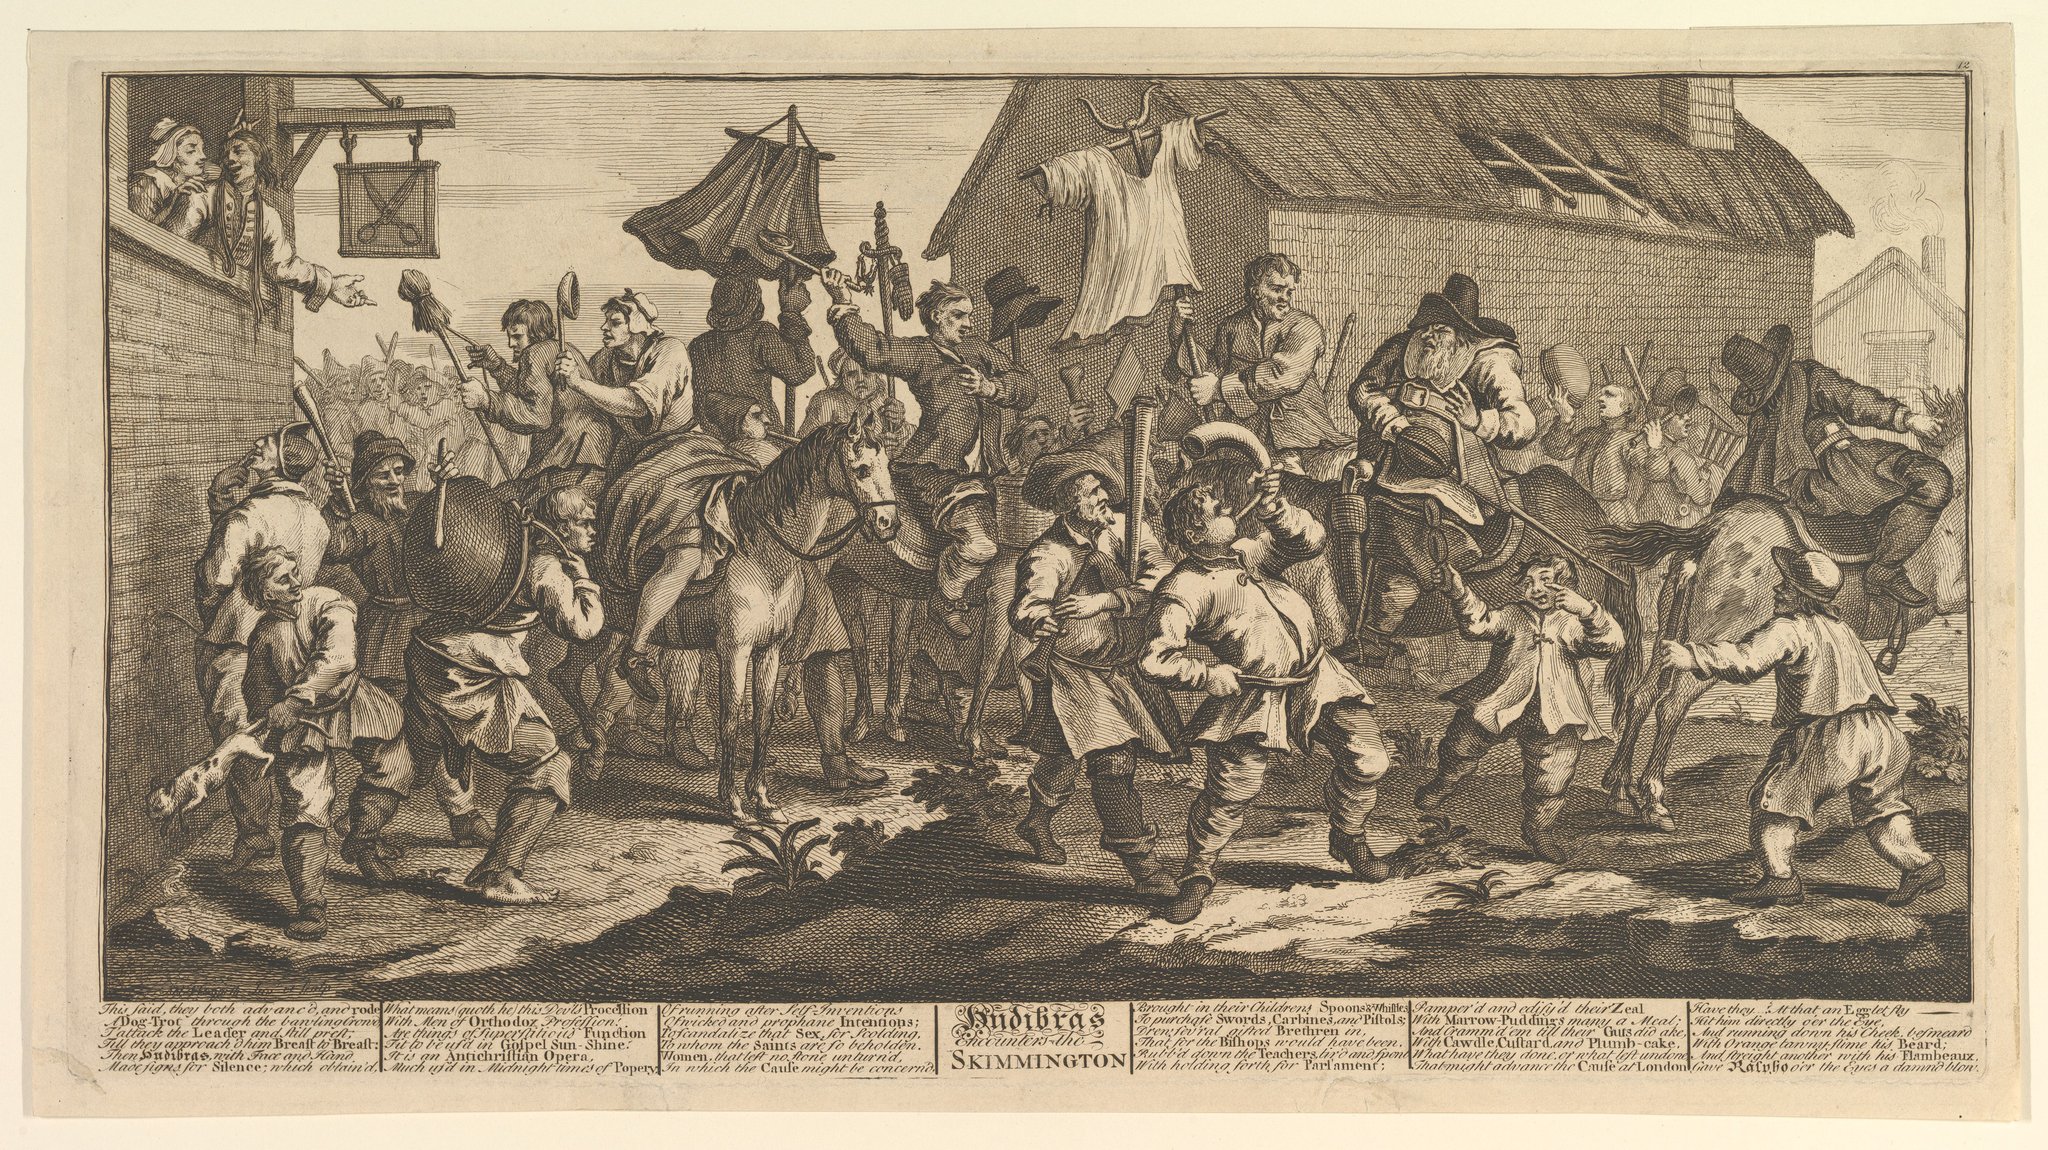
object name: print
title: Hudibras and the Skimmington (Twelve Large Illustrations for Samuel Butler's Hudibras, Plate 7)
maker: william hogarth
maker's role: artist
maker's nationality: british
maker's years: 1697-1764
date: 1725-1768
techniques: engraving, etching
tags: musical instruments,houses,men,horses